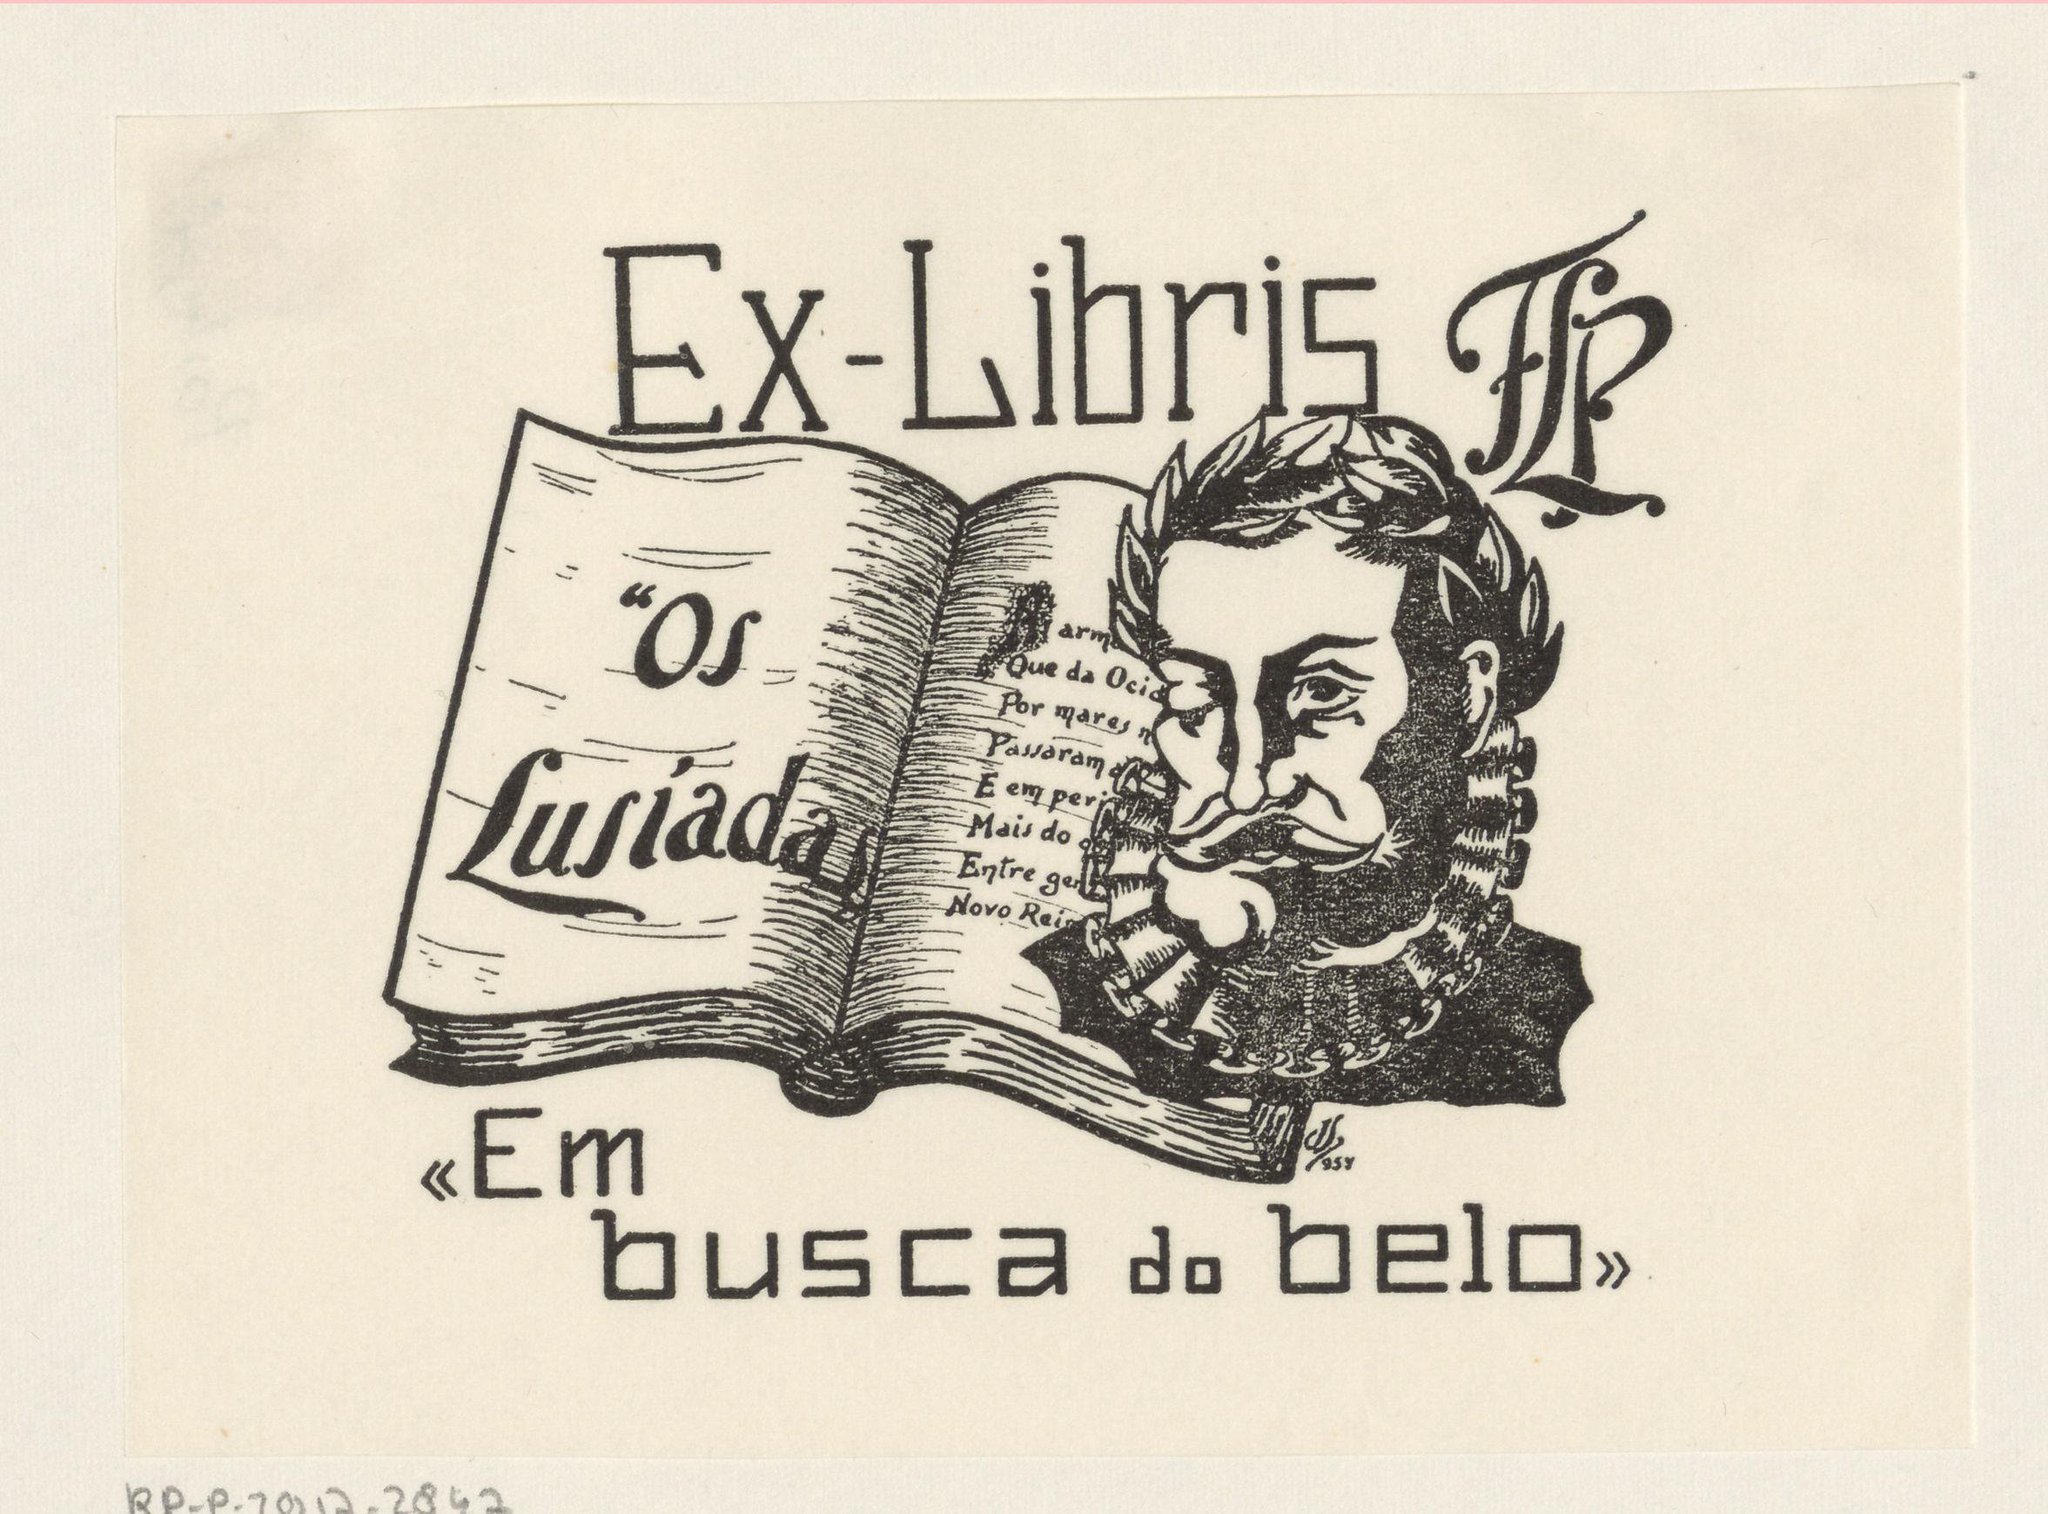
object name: bookplate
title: Ex libris van F.L.P.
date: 1957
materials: paper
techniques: printing block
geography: portugal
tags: portrait of a writer, book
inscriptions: date